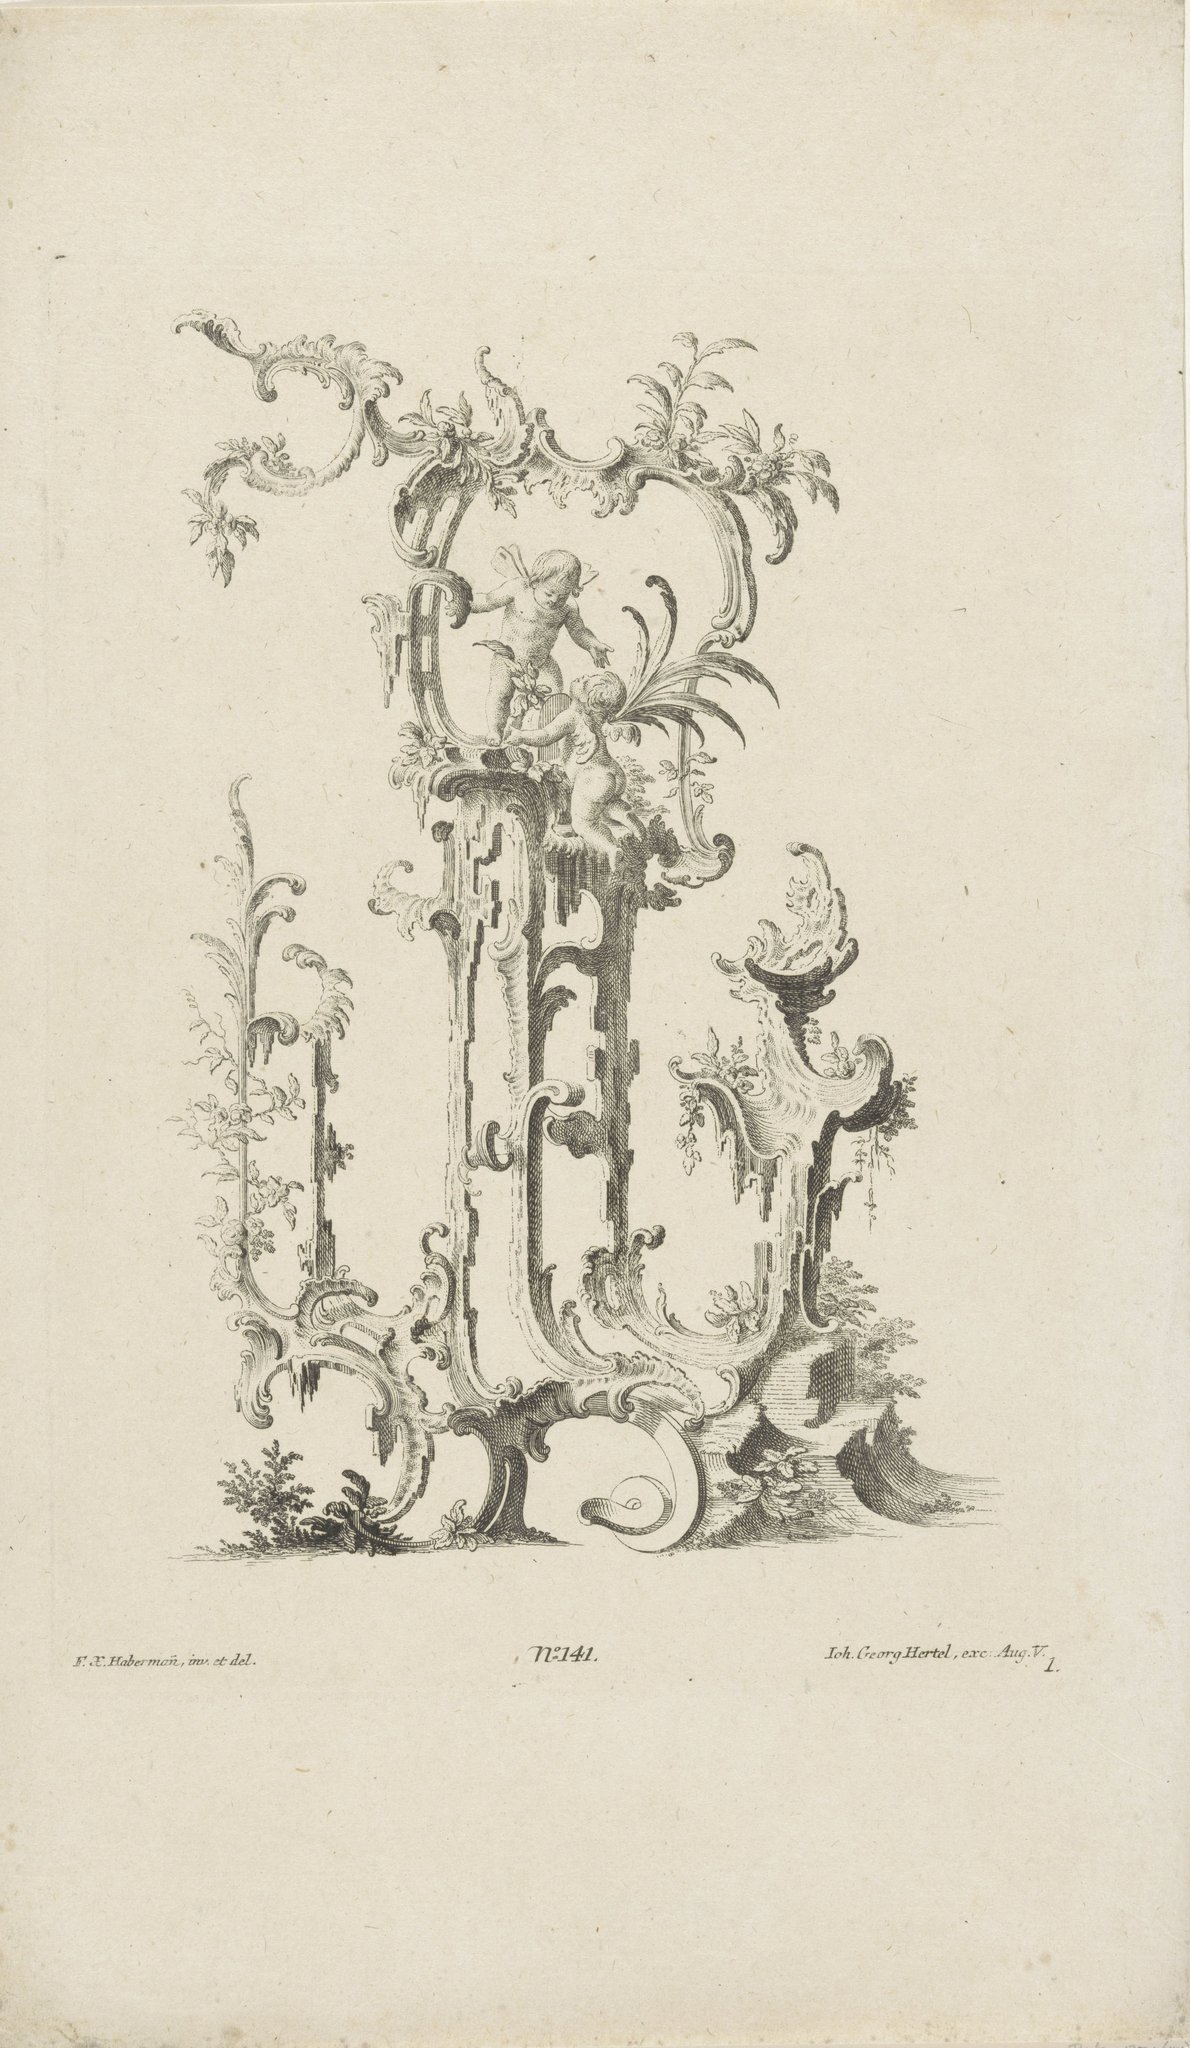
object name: ornament print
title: Rocailles met putti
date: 1731-1775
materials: paper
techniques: etching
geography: augsburg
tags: rocaille ornament, cupids: 'amores', 'amoretti', 'putti'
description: Rocaille ornamenten met bladmotieven en twee gevleugelde putti. Uitgeversnummer 141.